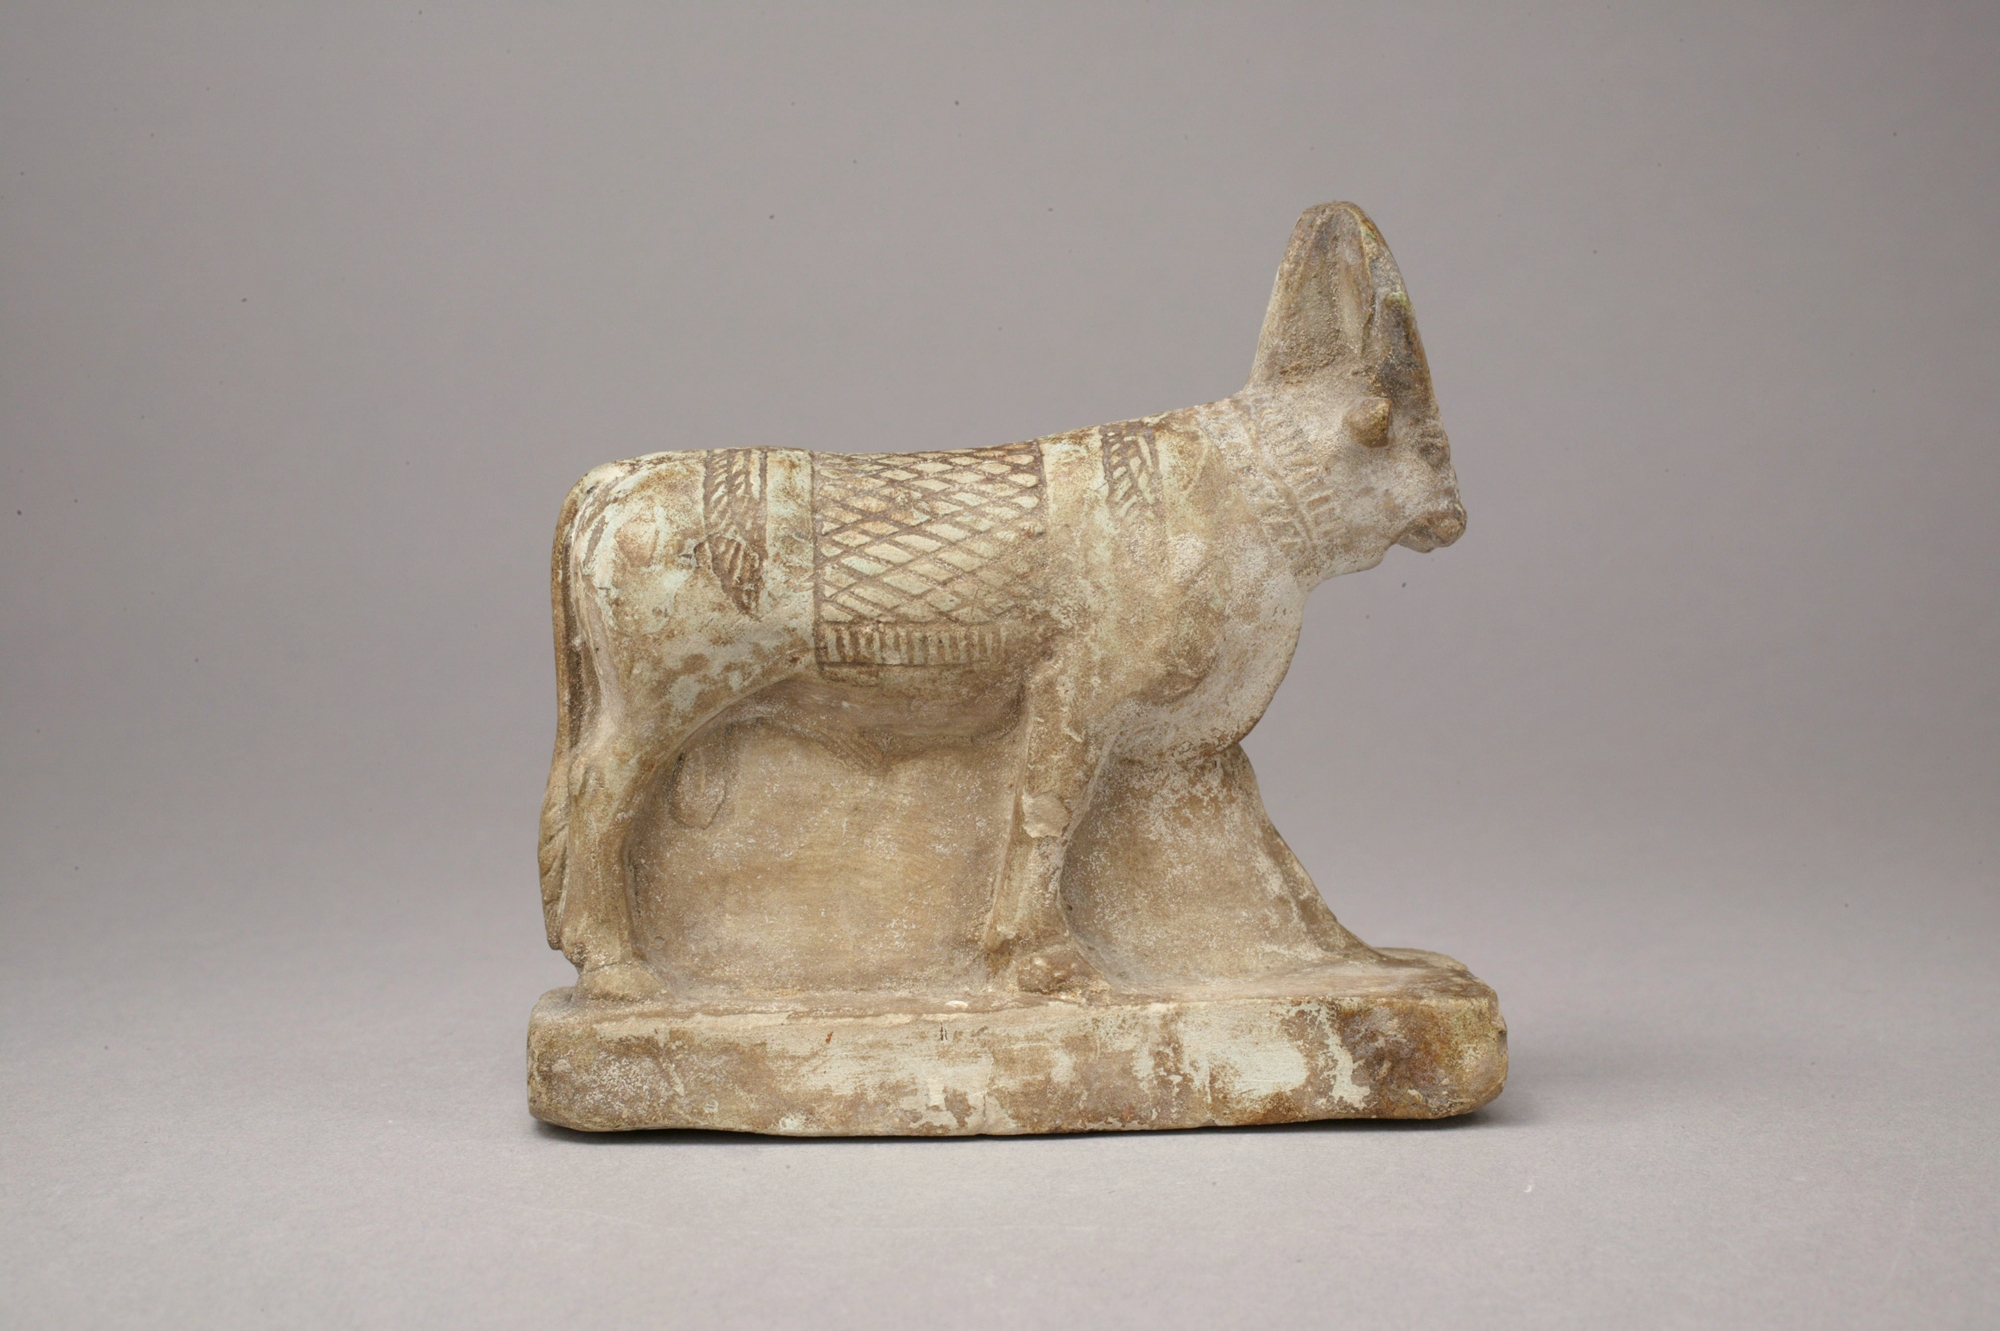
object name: apis figure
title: Apis Bull Figure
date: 664-332 BCE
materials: faience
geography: egypt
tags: bulls